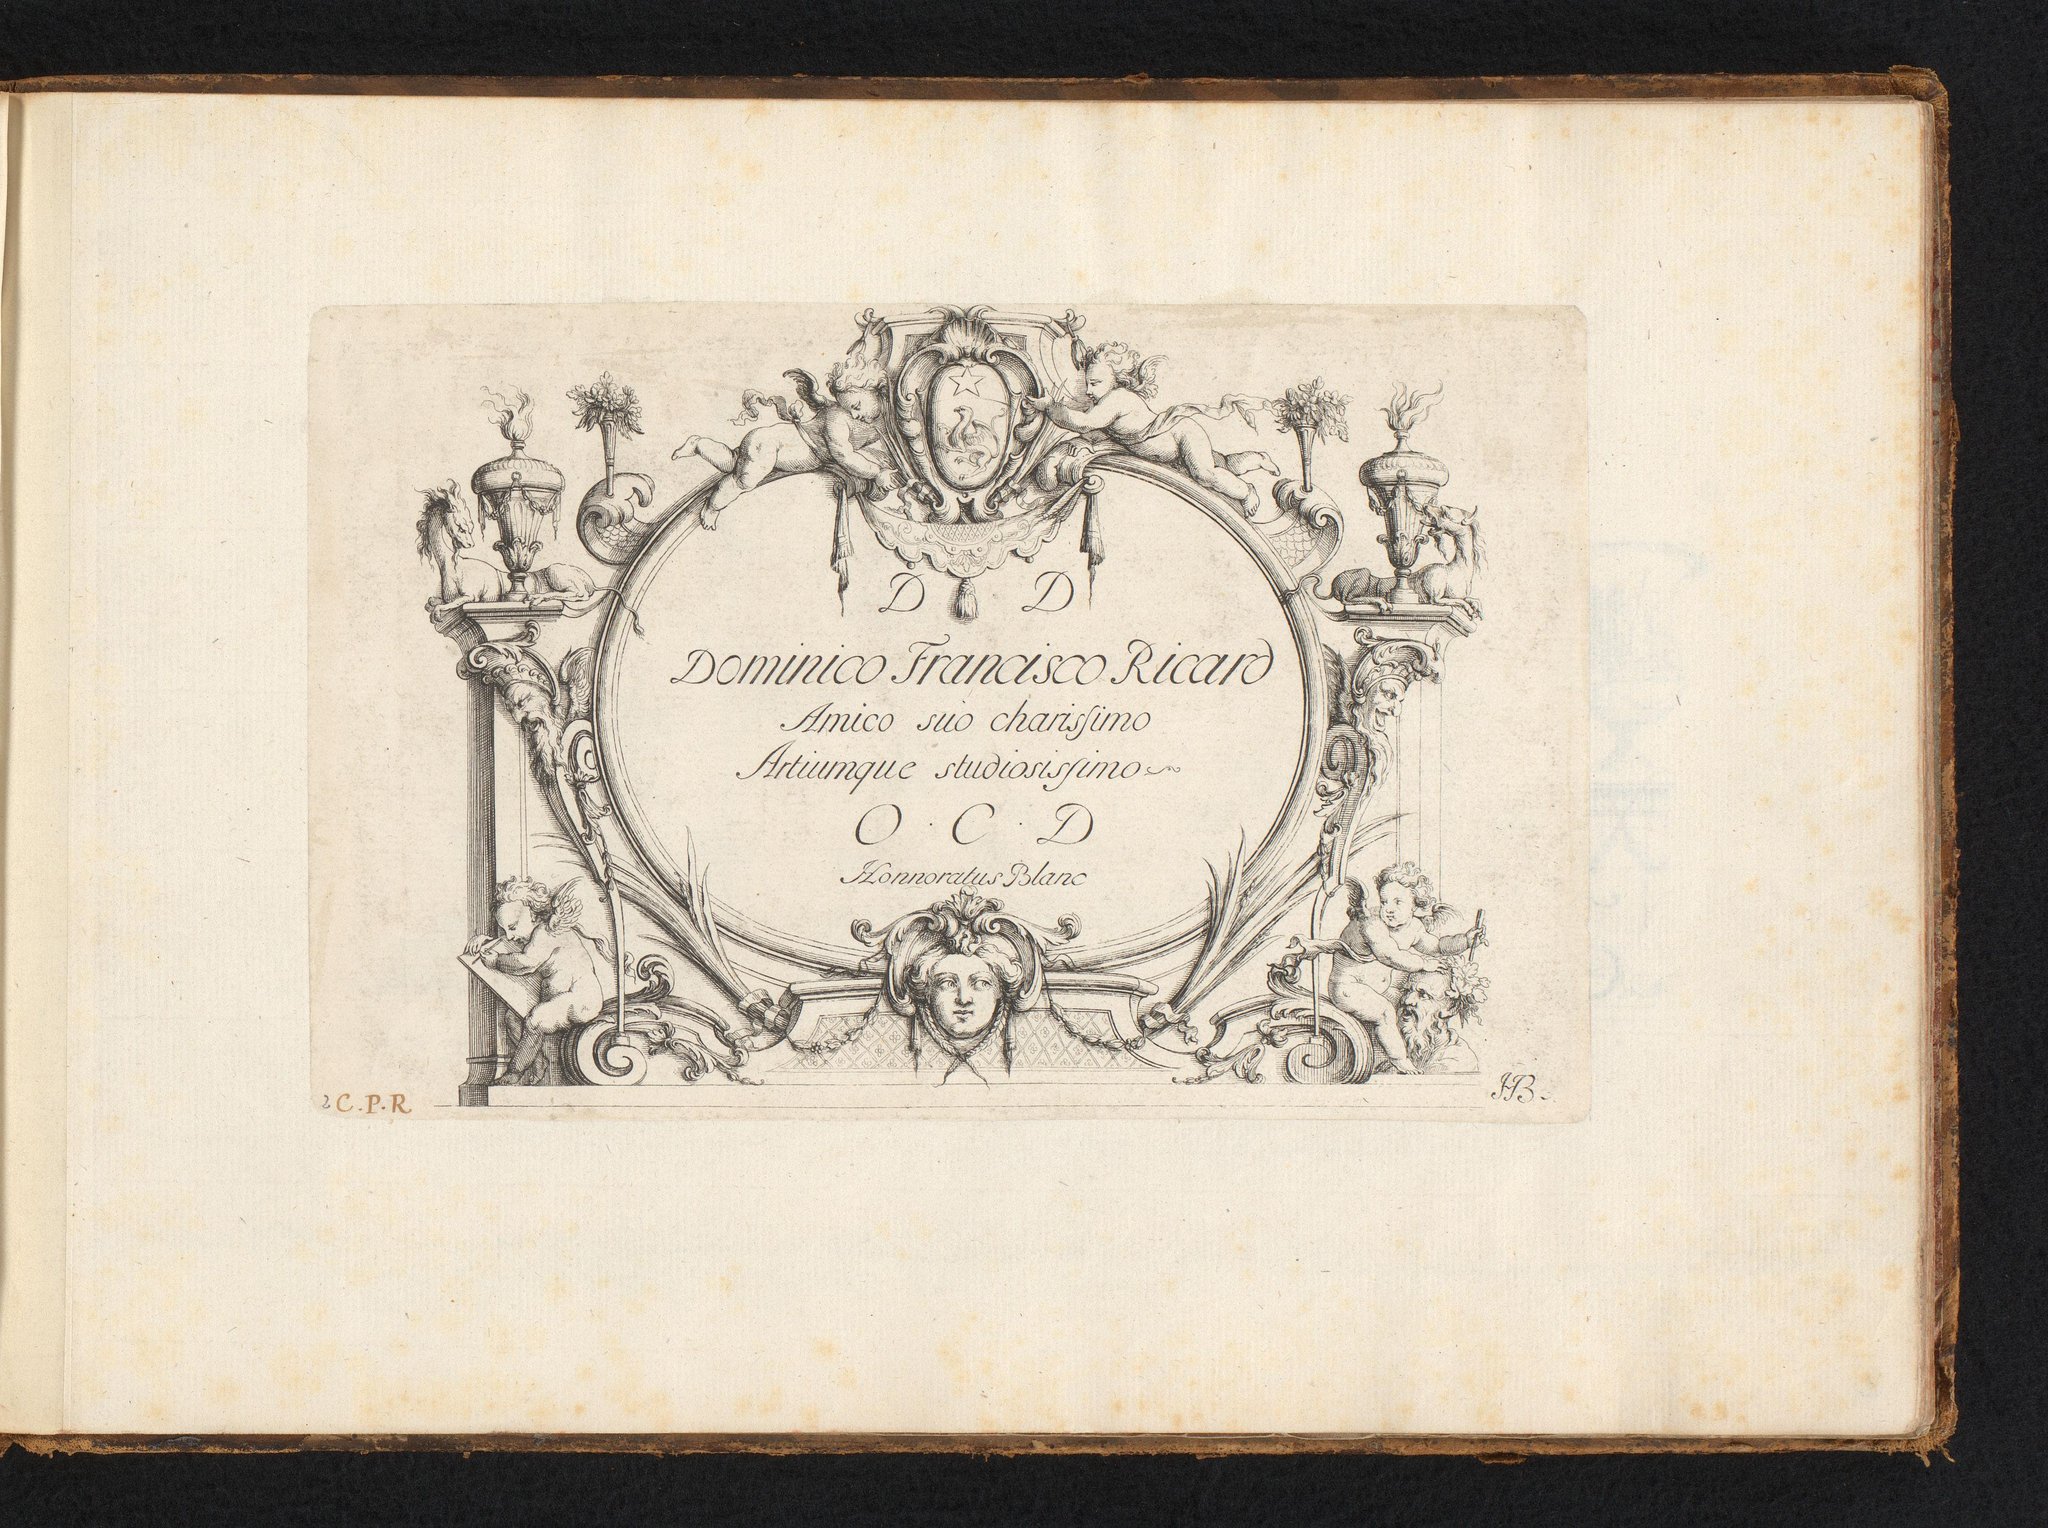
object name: print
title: Ornamenten met mascarons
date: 1682-1734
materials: paper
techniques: etching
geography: france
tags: mask, mascaron ~ ornament, cupids: 'amores', 'amoretti', 'putti'